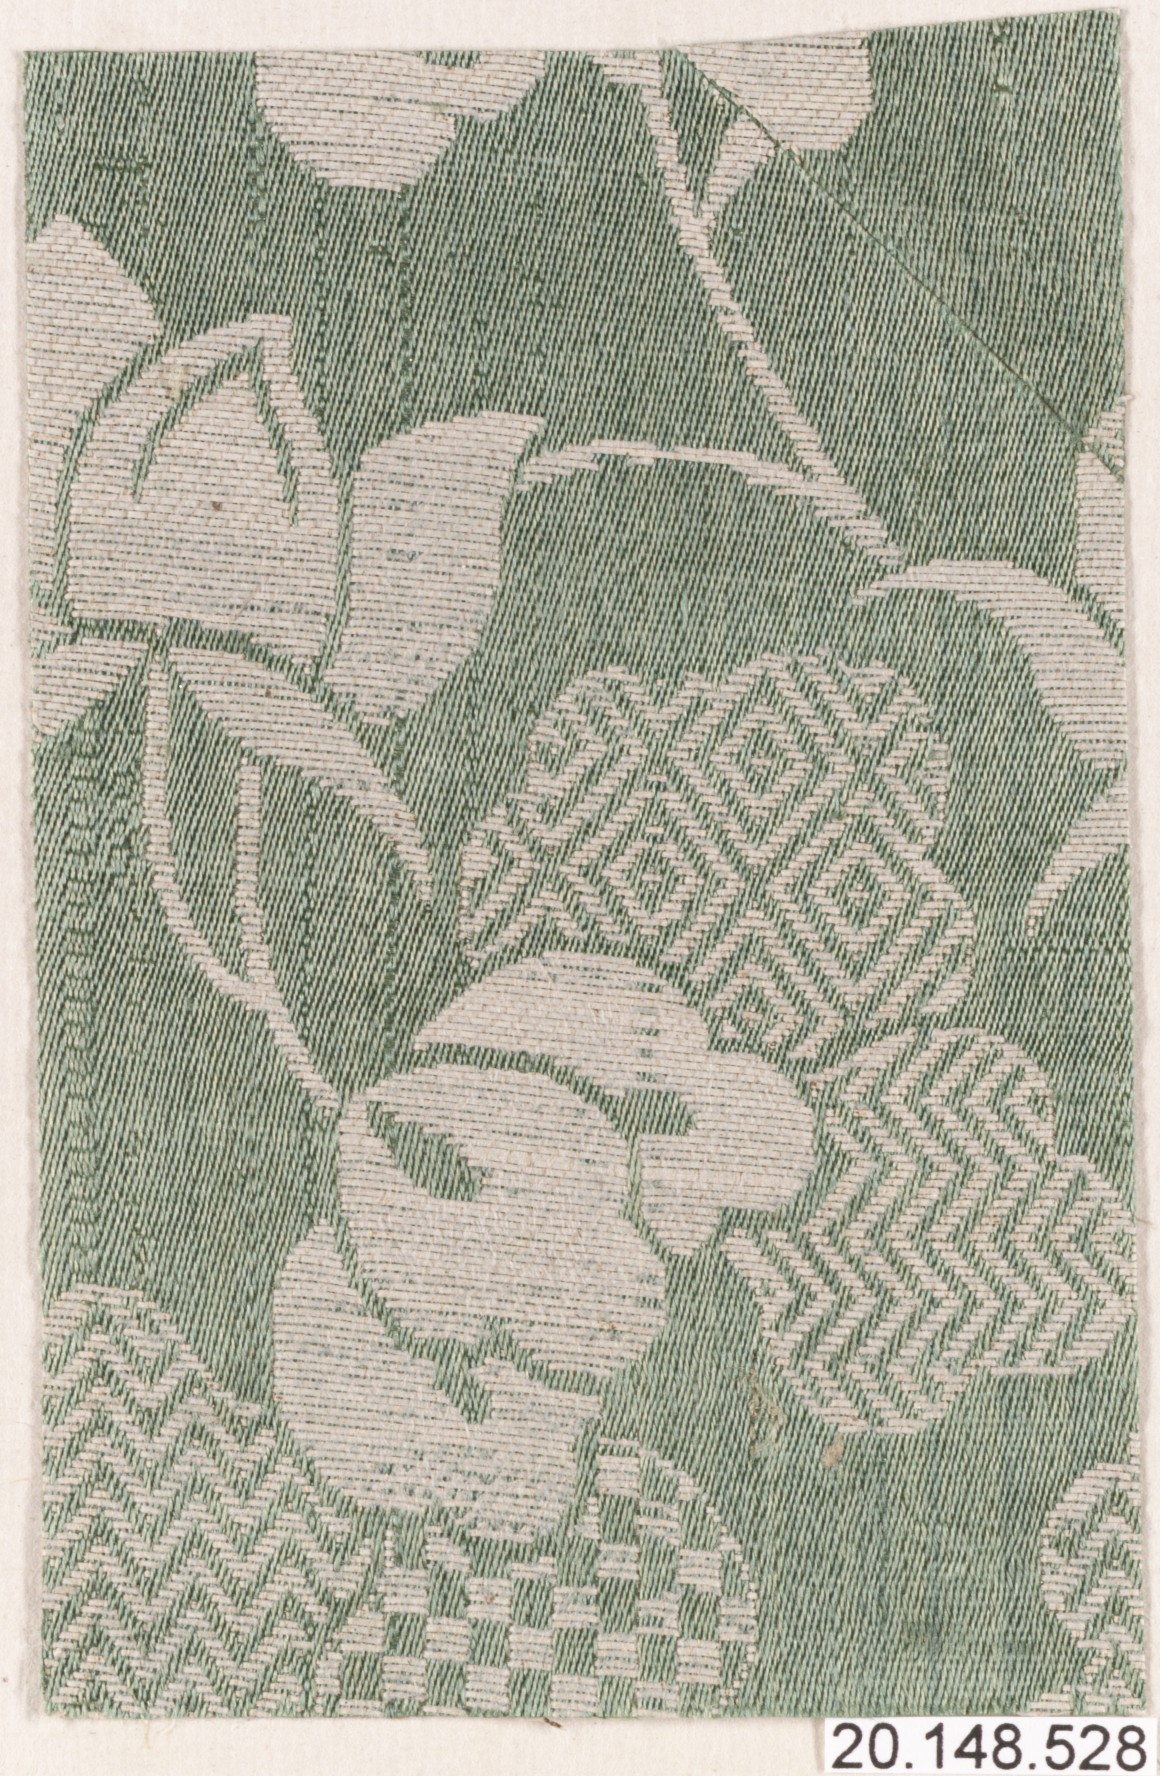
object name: piece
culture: japanese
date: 1701-1800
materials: silk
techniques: compound weave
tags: flowers